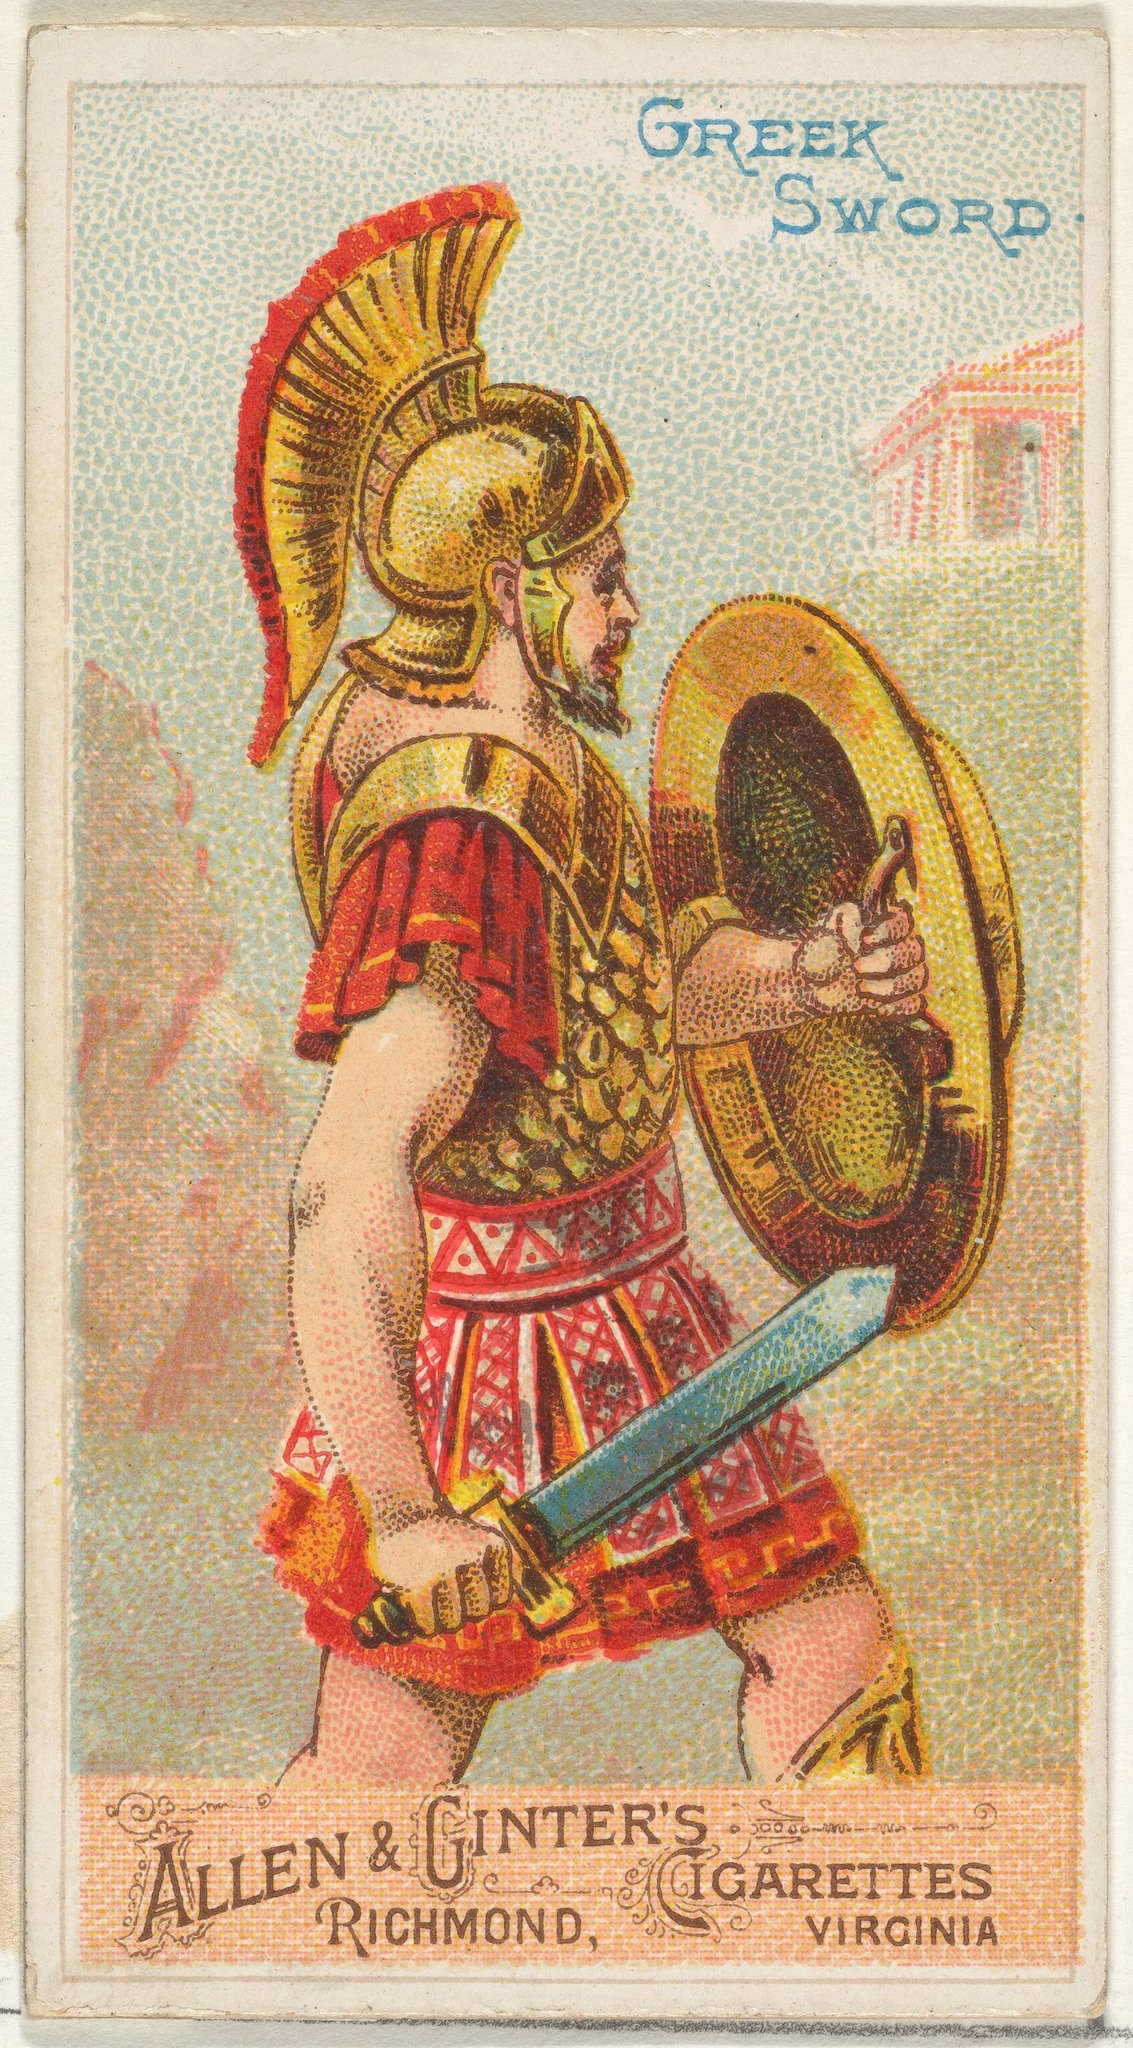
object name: print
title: Greek Sword, from the Arms of All Nations series (N3) for Allen & Ginter Cigarettes Brands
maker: allen & ginter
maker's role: publisher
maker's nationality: american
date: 1887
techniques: color lithograph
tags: soldiers,shields,swords